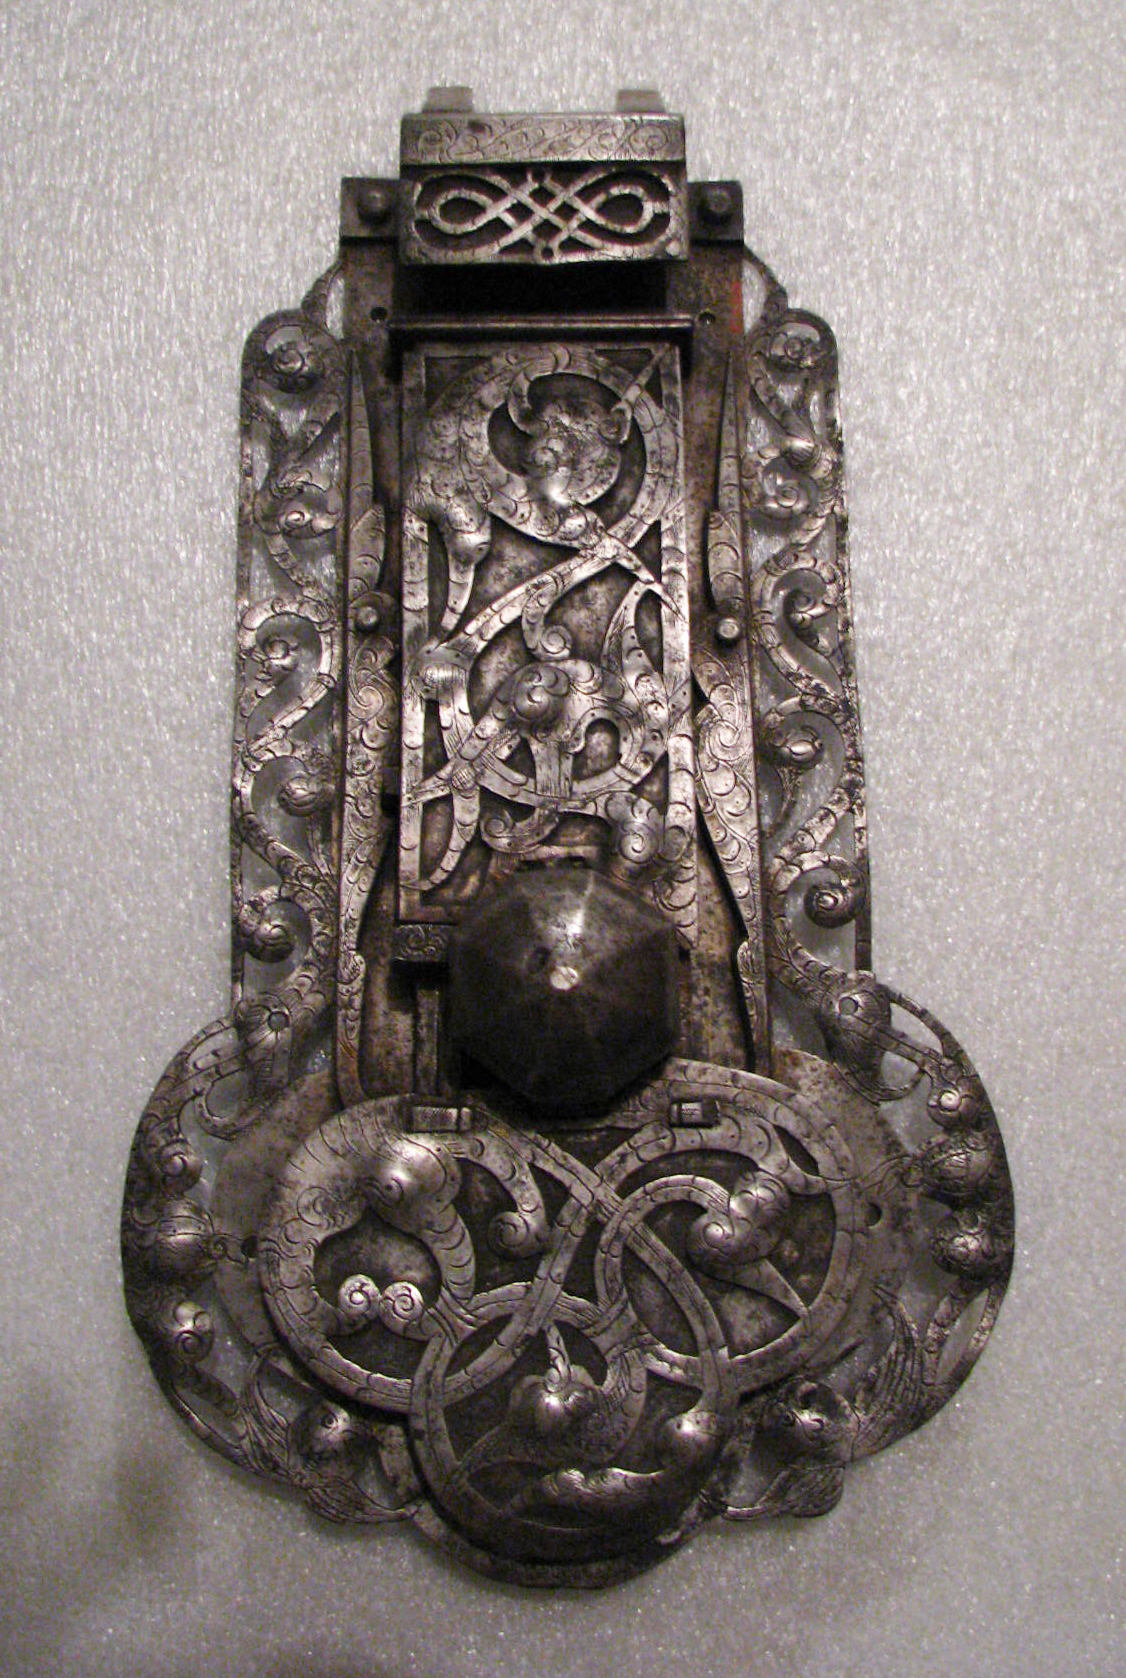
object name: rim lock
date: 1580-1620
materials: iron